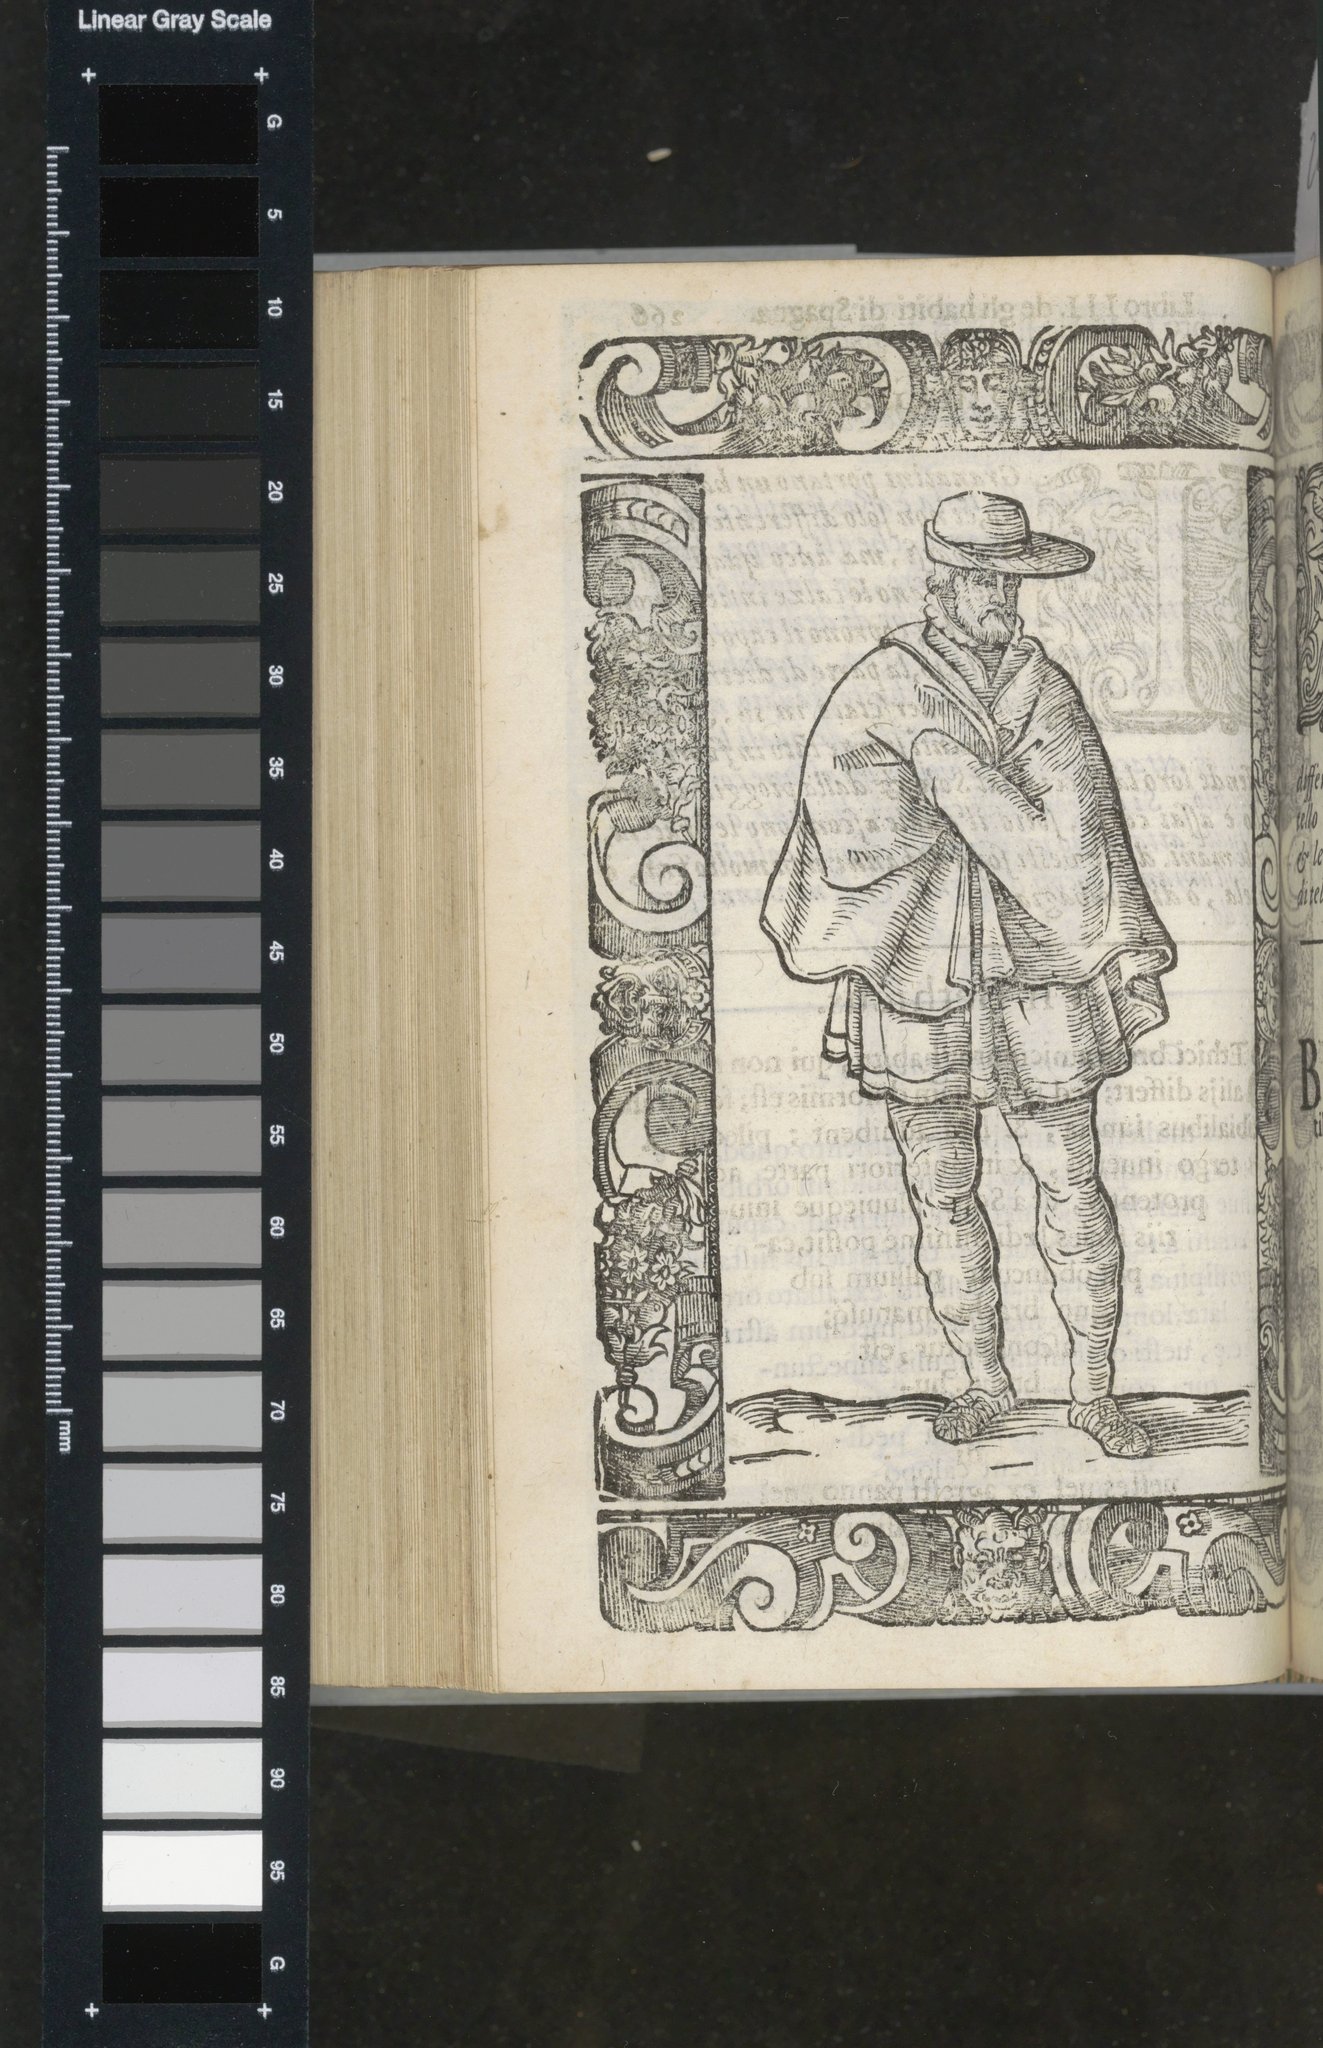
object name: costume print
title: Man uit Granada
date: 1598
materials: paper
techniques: woodcut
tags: cape (+ men's clothes), head-gear: cap (+ men's clothes)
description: Man uit Granada, in korte schoudermantel. Pet met grote klep op het hoofd. In ornamentrand.